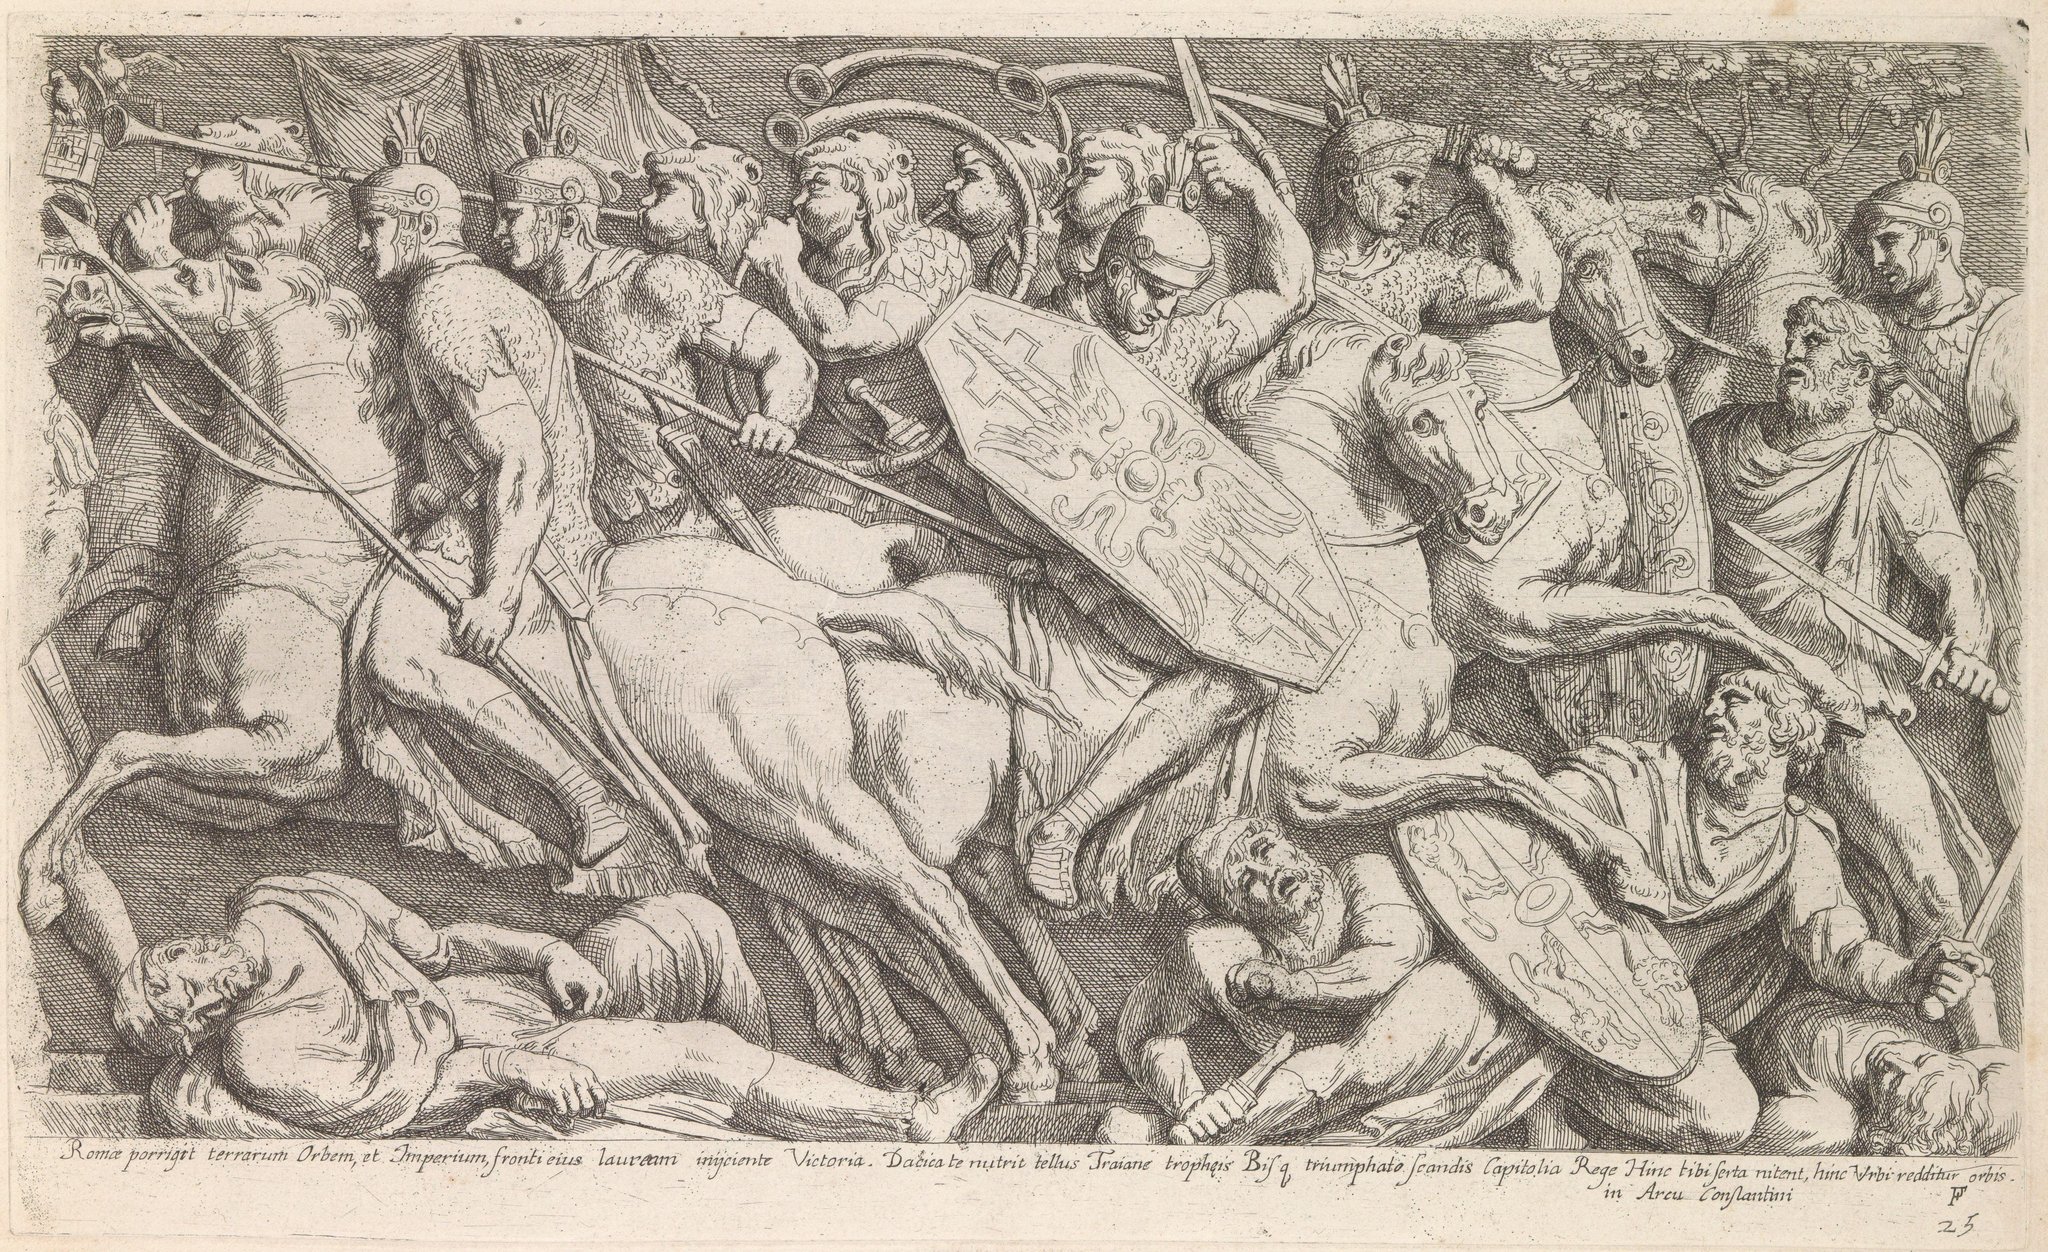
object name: album leaf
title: Icones et segment (...)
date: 1645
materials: paper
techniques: etching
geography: paris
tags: battle, piece of sculpture, reproduction of a piece of sculpture, the soldier; the soldier's life, the soldier; the soldier's life (+ cavalry, horsemen), arch of constantine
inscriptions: number: ‘52’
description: Deze prent maakt deel uit van een reeks van 54 prenten (+ titelprent) naar antieke reliëfs. De nummering op de prenten loopt van 1 tot en met 50. Sommige prenten hebben dubbele nummers. Naar de reliëfs op de Boog van Constantijn te Rome.